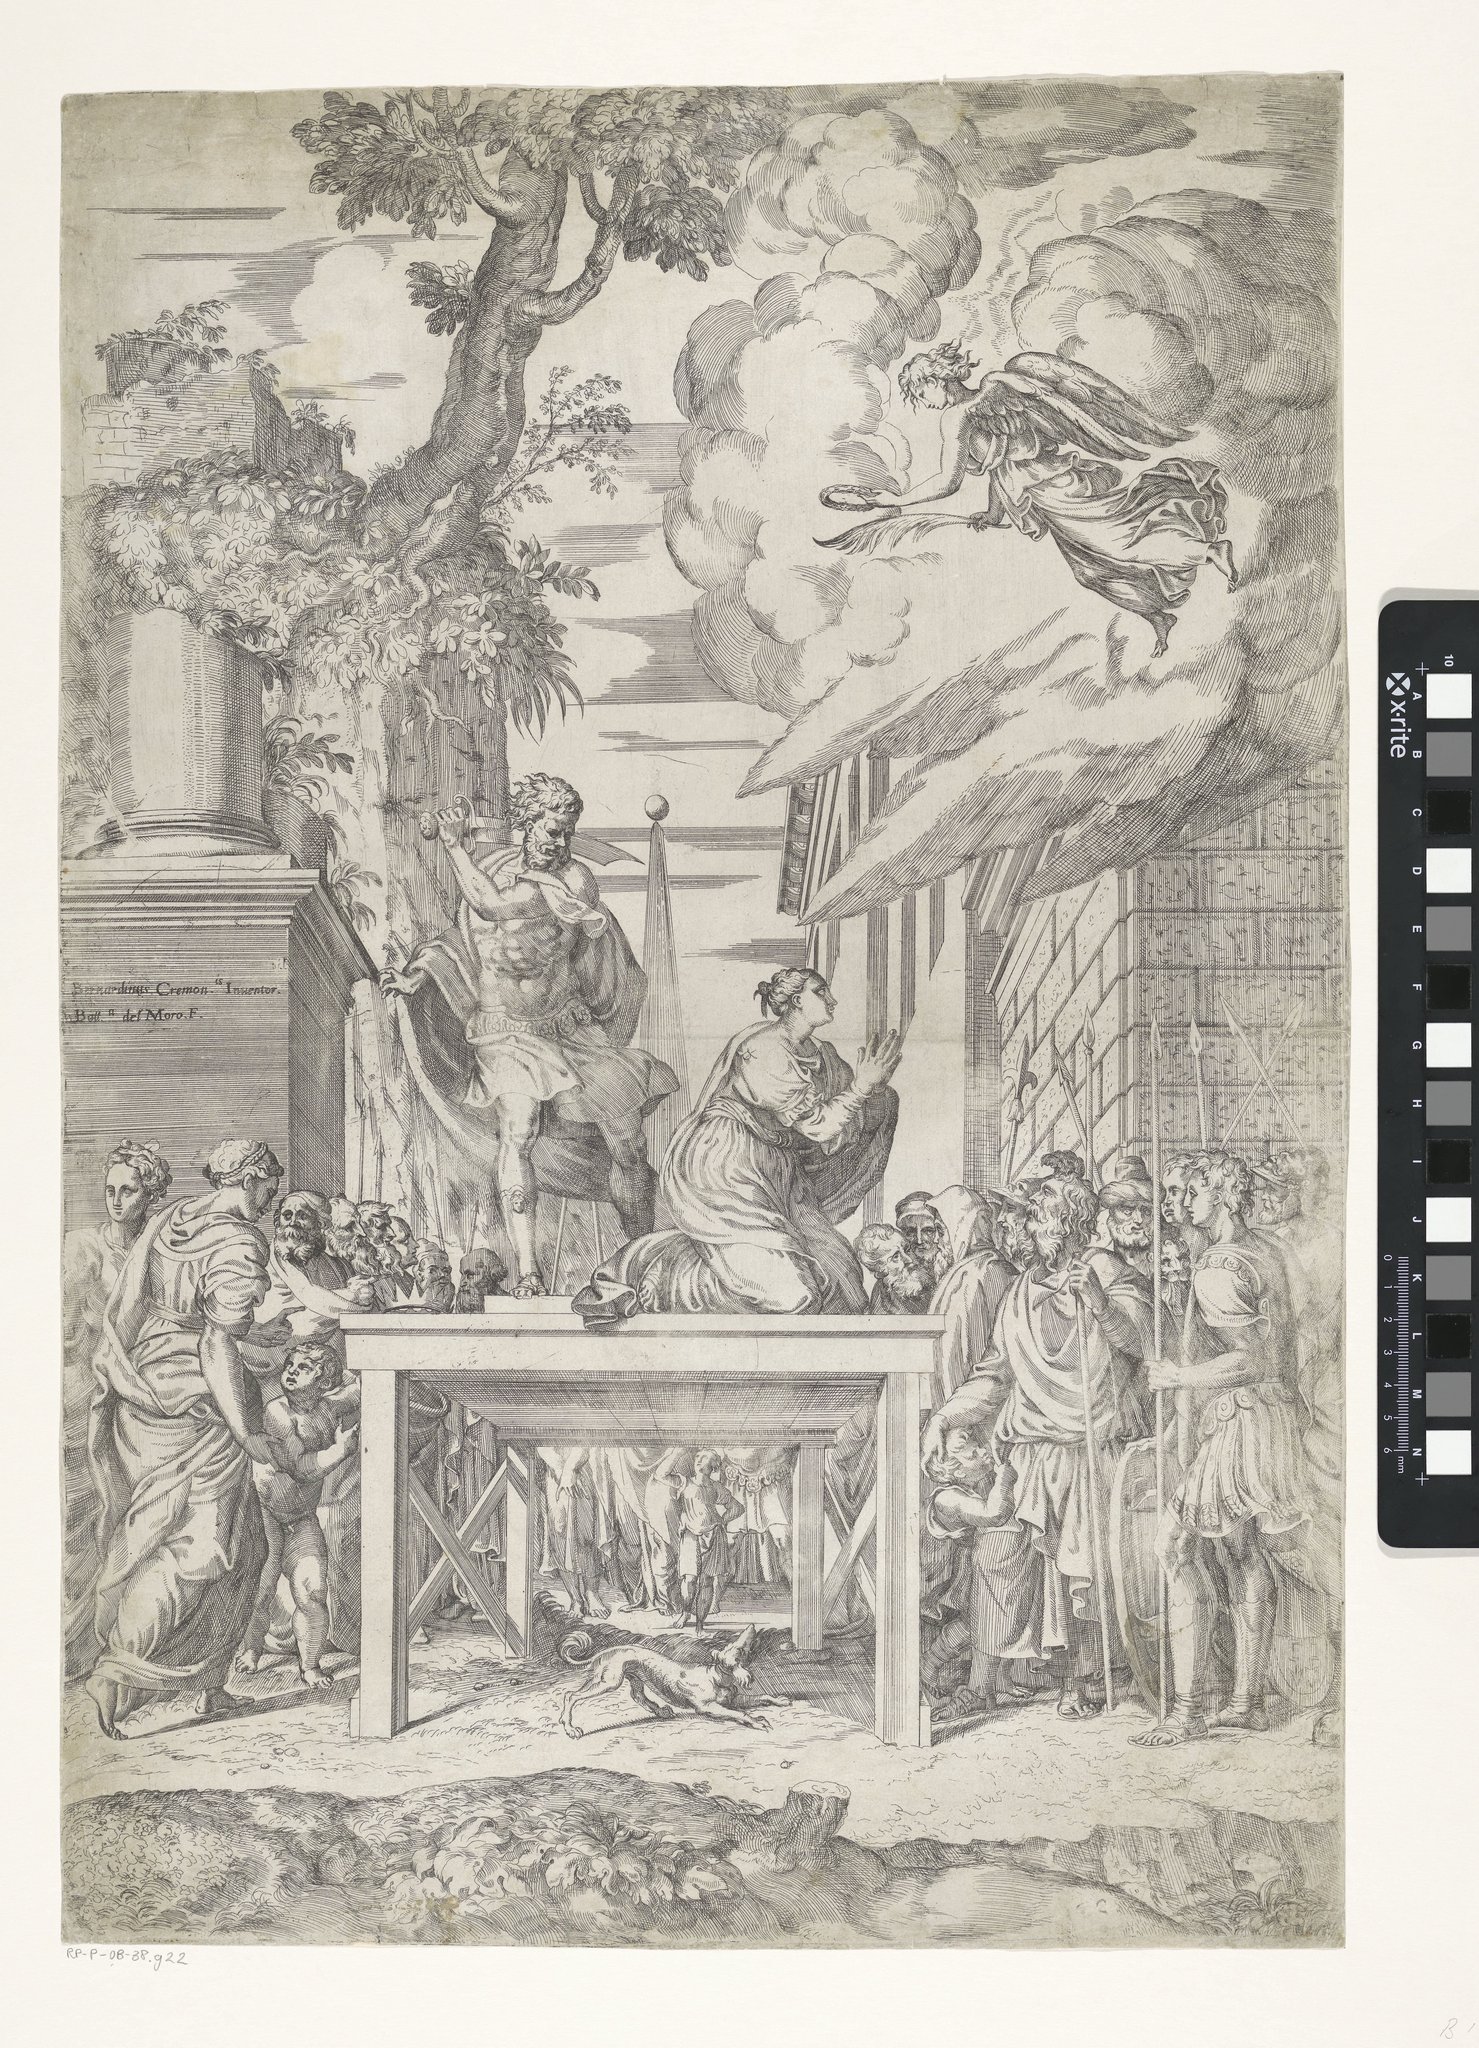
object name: print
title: Martelaarschap van de heilige Justina van Antiochië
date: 1524-1575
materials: paper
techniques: etching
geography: cremona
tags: violent death by beheading, female saints, angels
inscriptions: collector's mark: Lugt 240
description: Justina van Antiochië zit geknield op een schavot met haar rug naar een beul die op het punt staat haar te onthoofden met een zwaard. Een menigte kijkt toe. In de lucht komt een engel aangevlogen met een palmtak en een lauwerkrans.